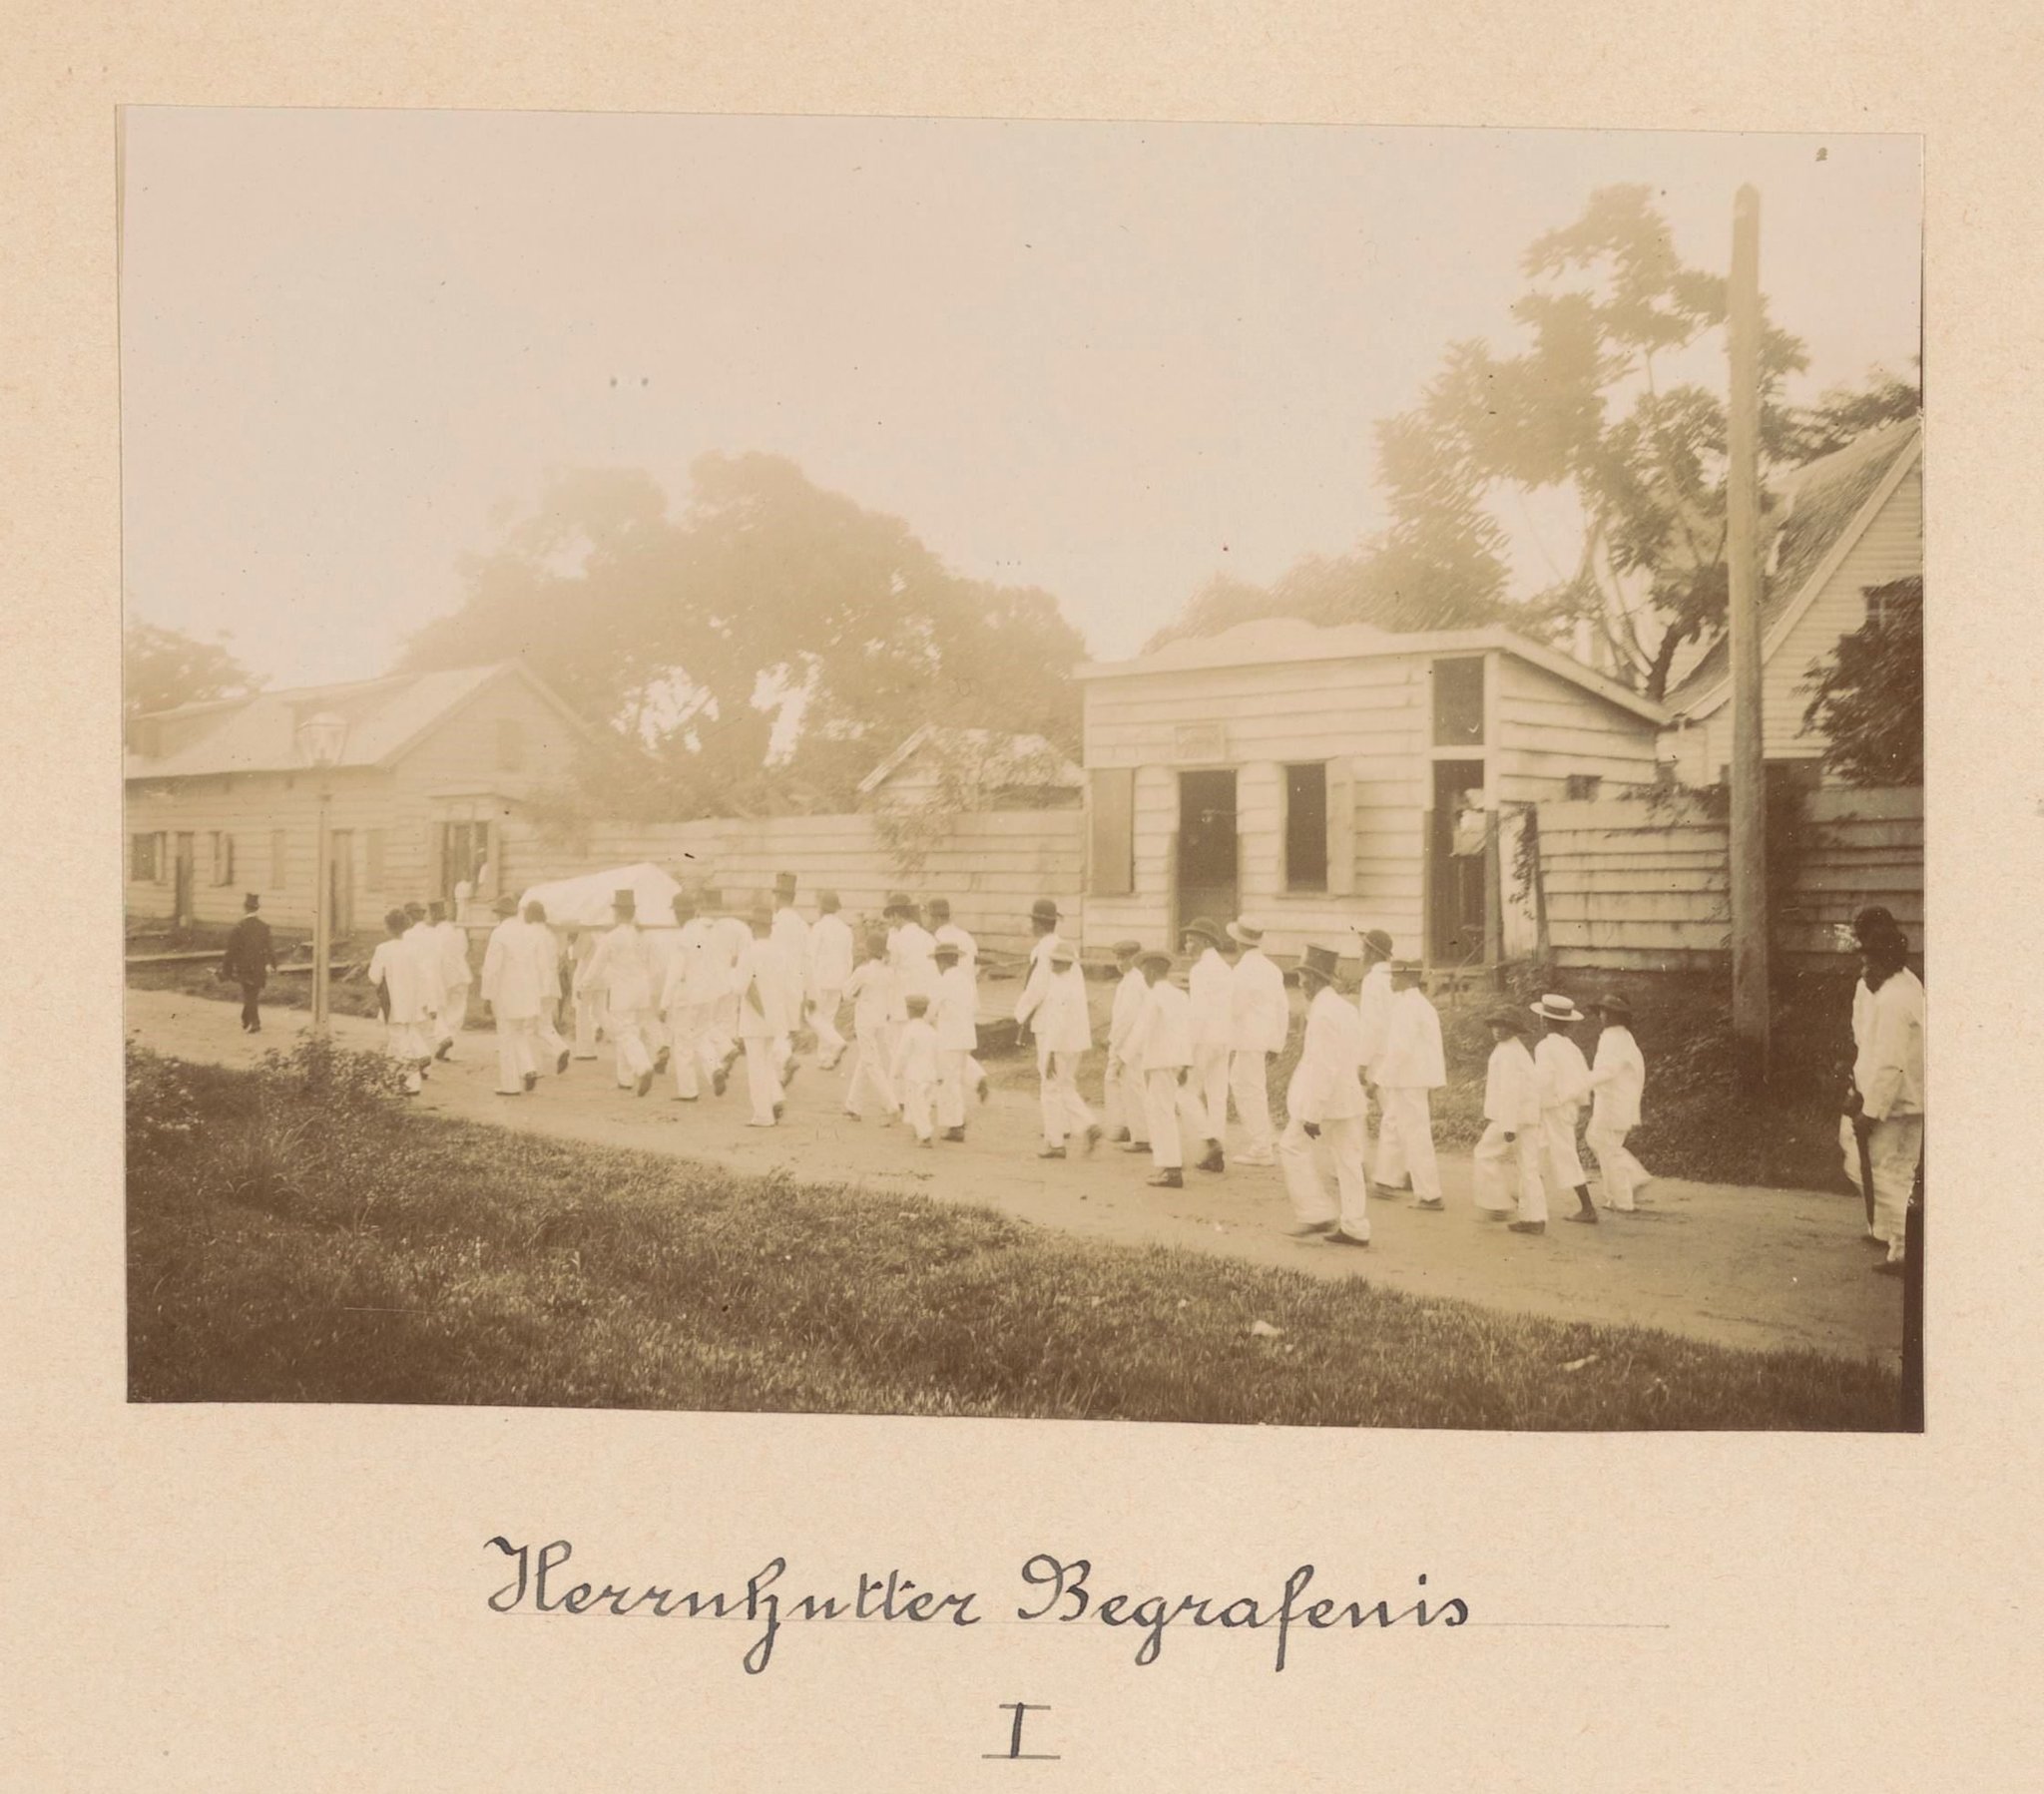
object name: photograph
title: Herrnhutter Begrafenis I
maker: eugen klein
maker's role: fotograaf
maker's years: 1869-1927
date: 1900-1905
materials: cardboard, photographic support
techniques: gelatin silver print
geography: paramaribo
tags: congregatie, evangelische broedergemeente, paramaribo (stad)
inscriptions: inscription: ‘Paramaribo / Herrnhutter Begrafenis I’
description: Begrafenis van Hernhutters van de Evangelische Broedergemeente te Paramaribo. Een stoet mannen in witte kleding lopend door een straat. Onderdeel van een groep van 44 foto's van Paramaribo, Suriname en Curaçao, ca. 1900-1905, opgeplakt op kartons en voorzien van opschriften.